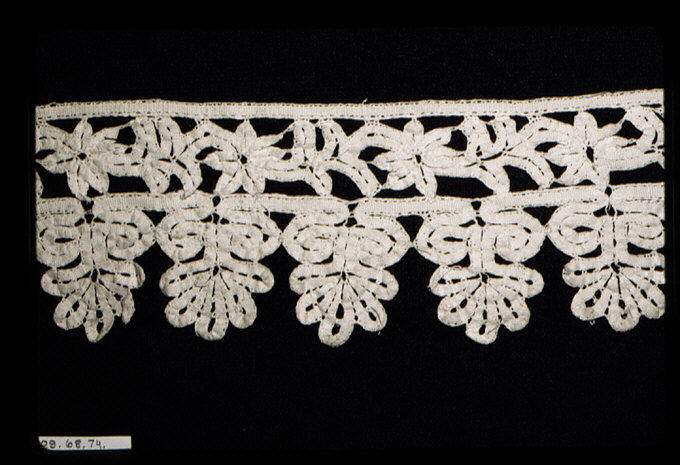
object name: border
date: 1501-1600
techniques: lace